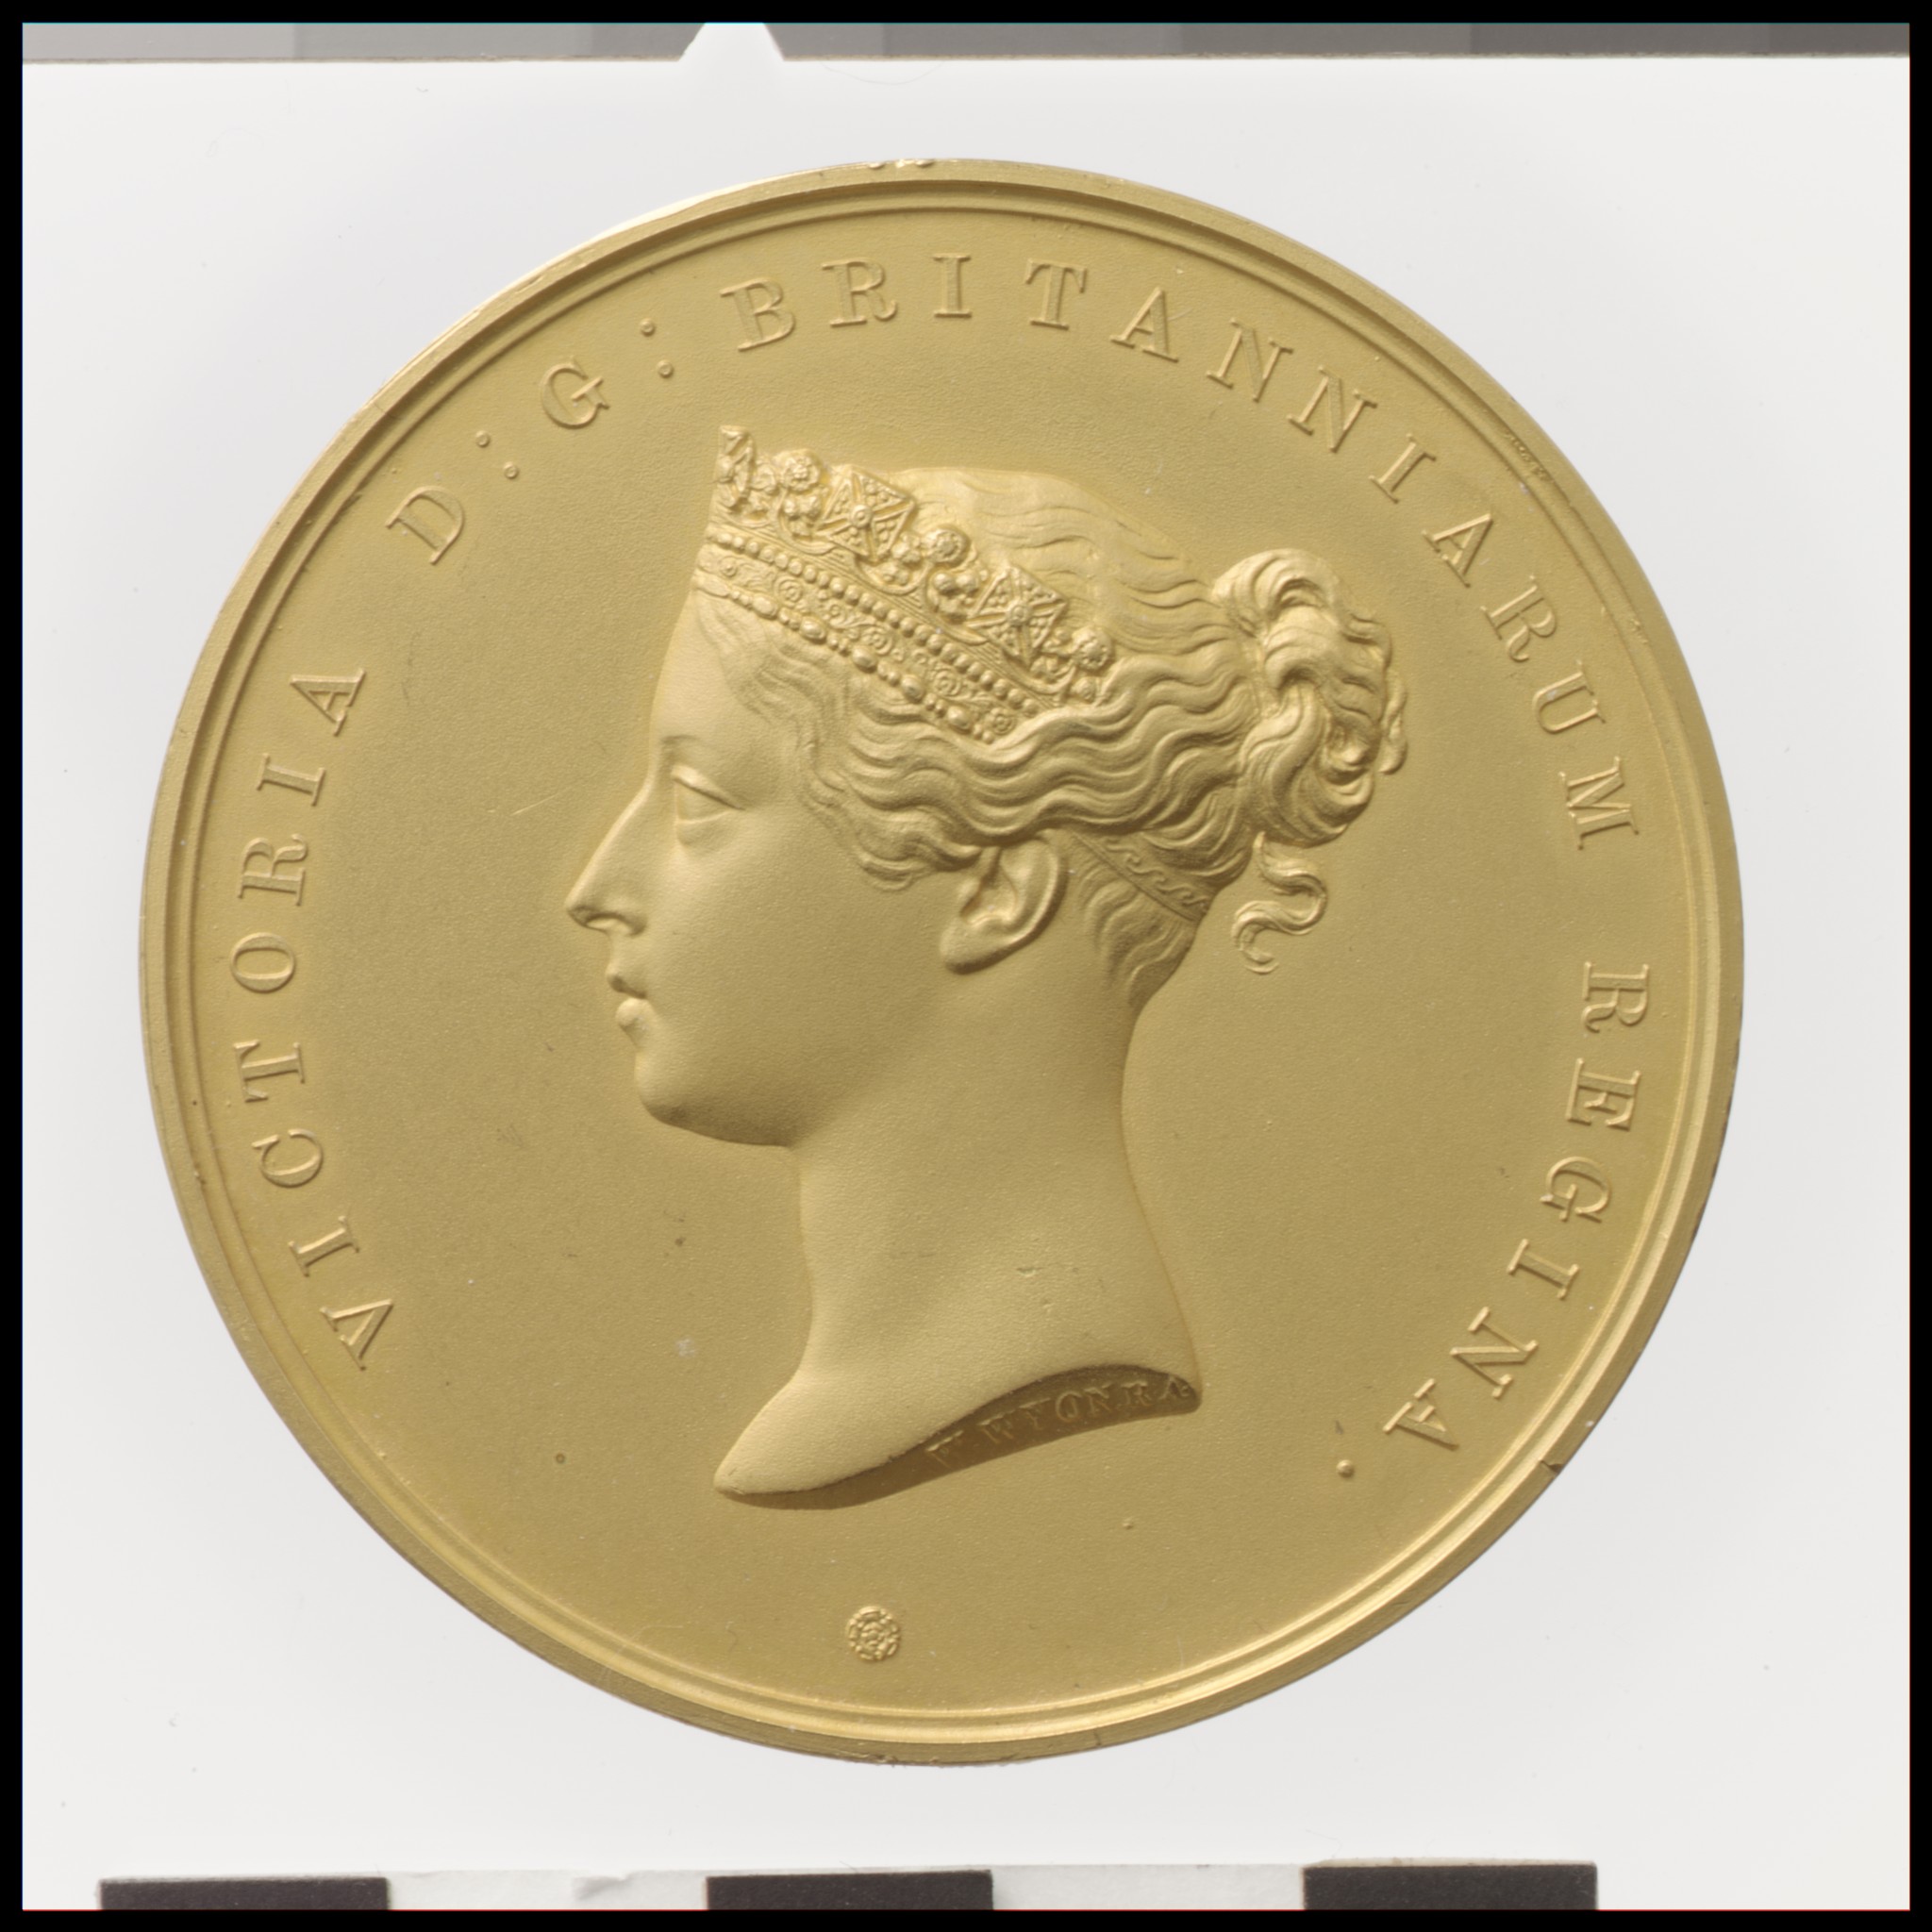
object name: medal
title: Queen Victoria (1819–1901), with poet on reverse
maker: william wyon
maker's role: artist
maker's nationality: british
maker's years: 1795-1851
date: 1840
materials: gold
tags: men,profiles,women,poets